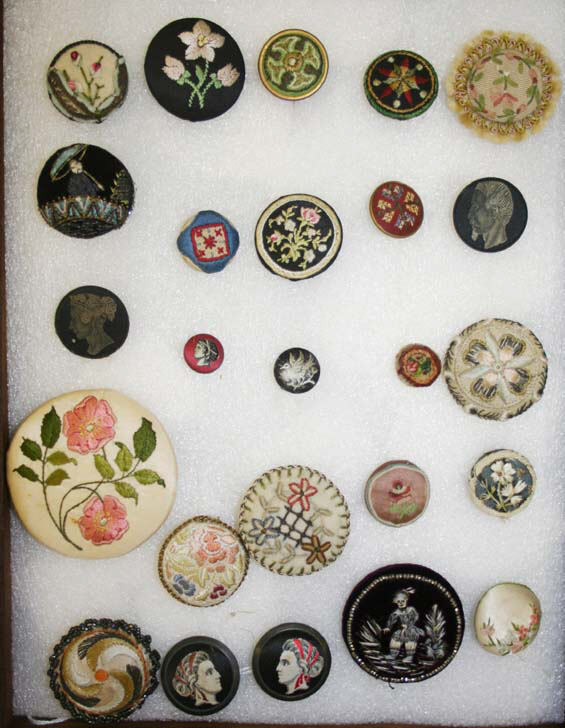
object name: button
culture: american or european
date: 1830-1880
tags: profiles,flowers